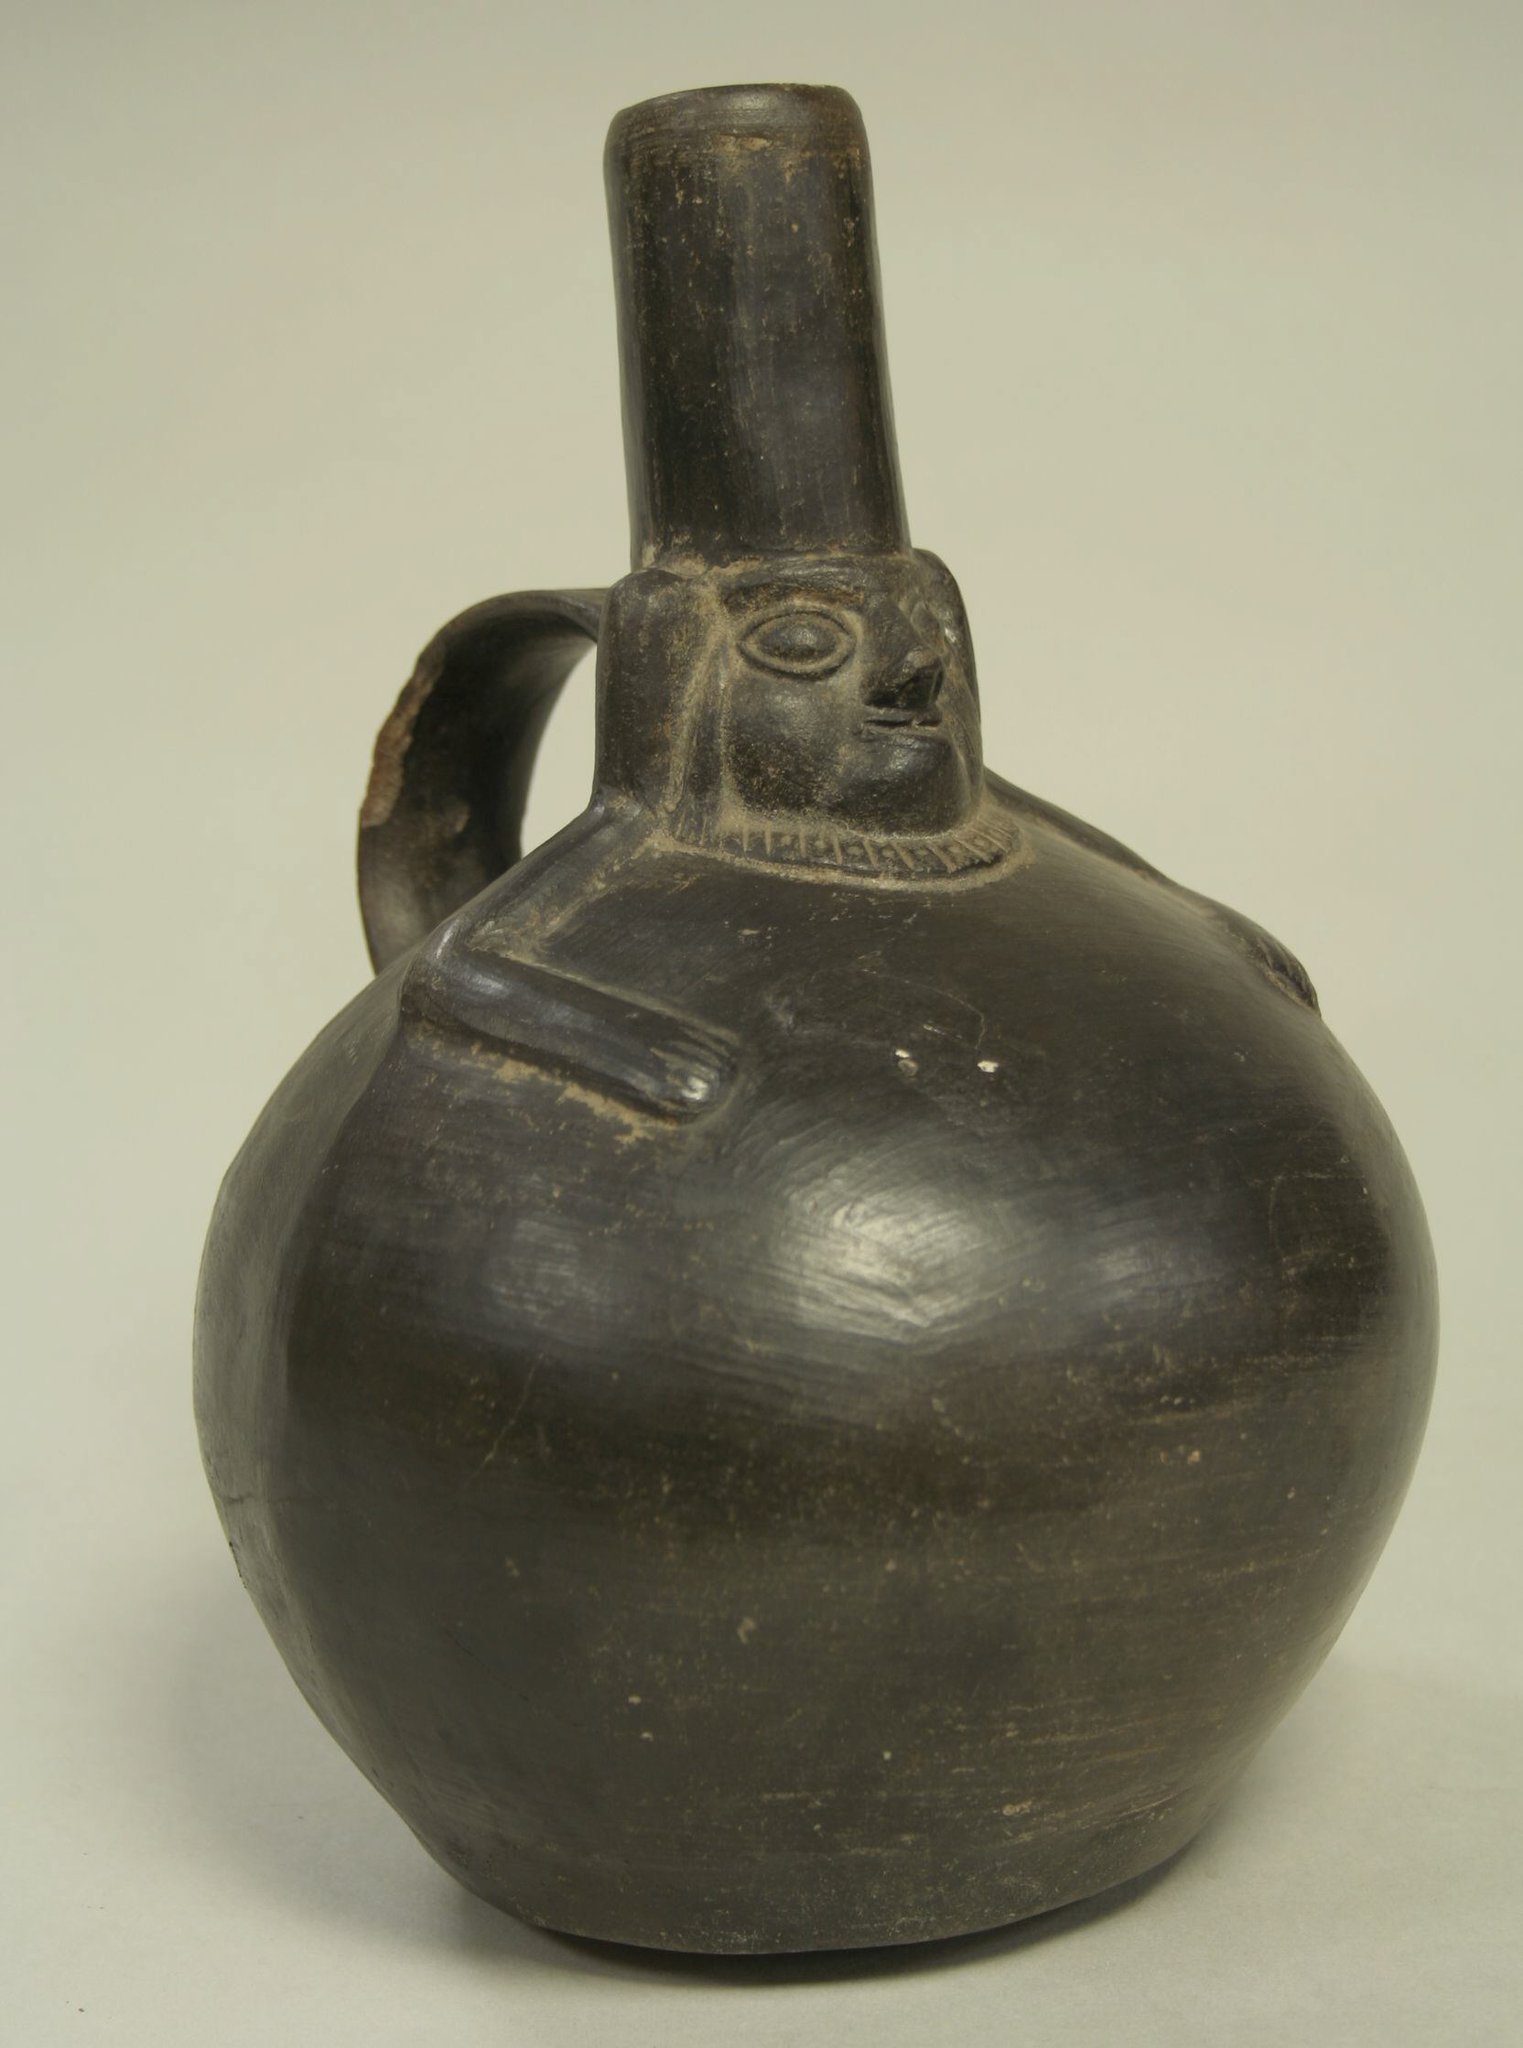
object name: bottle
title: Single Spout Bottle with Strap Handle and Face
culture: chimú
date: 1301-1466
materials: ceramic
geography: peru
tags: faces